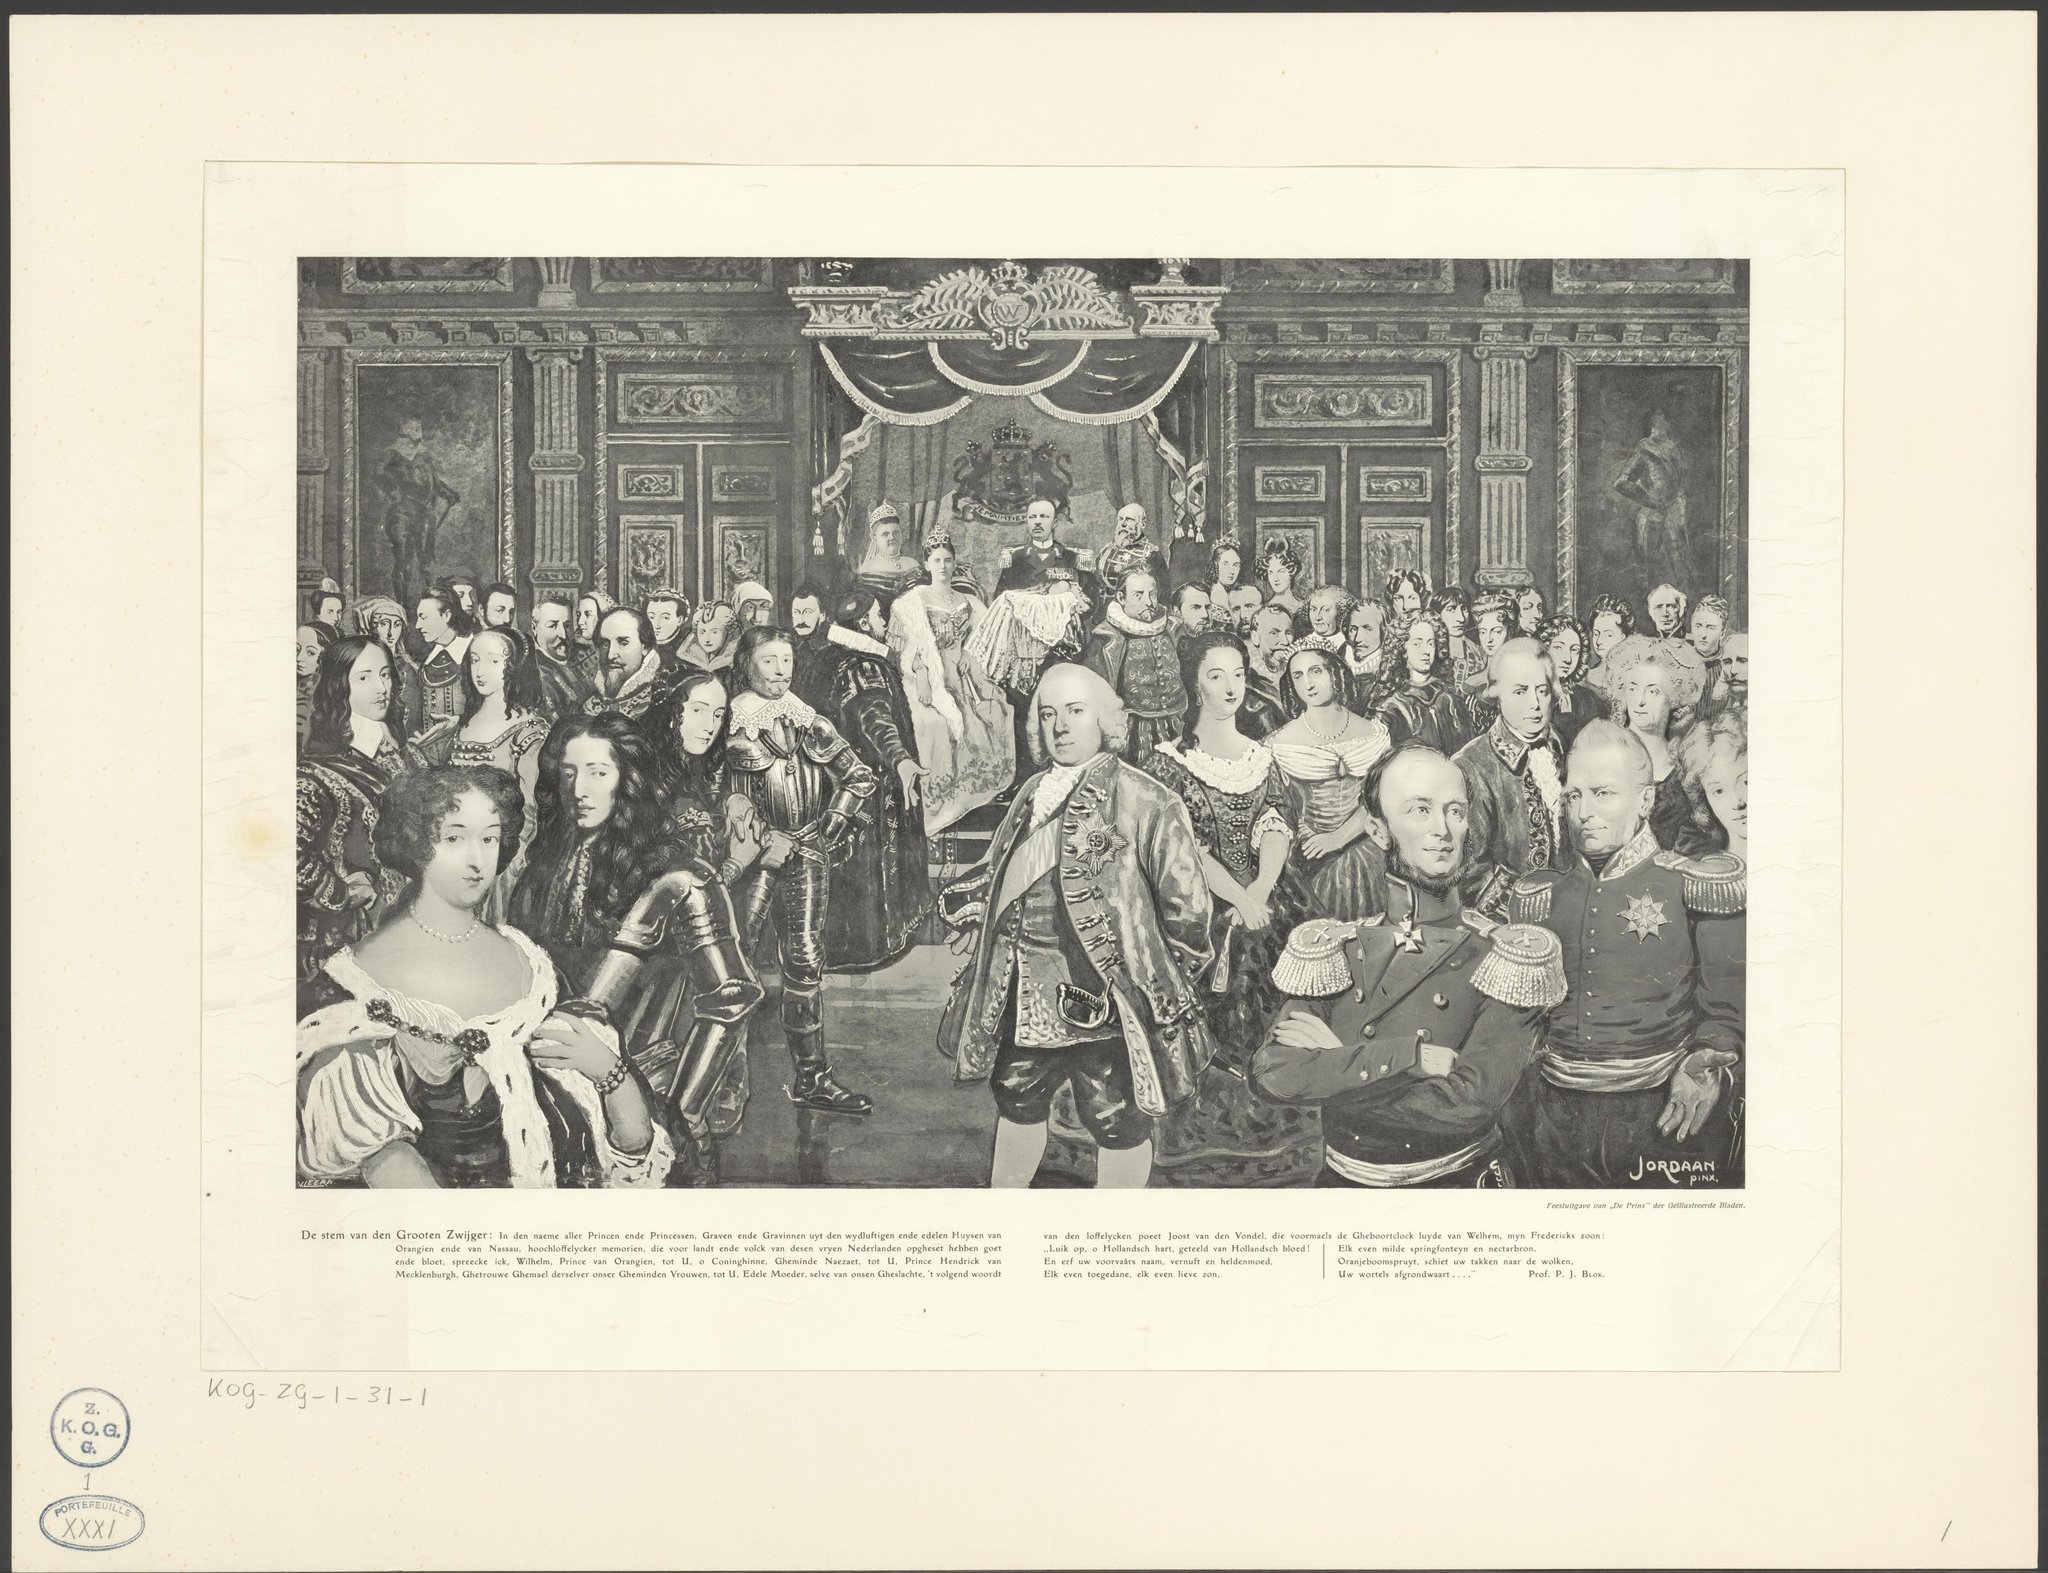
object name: photomechanical print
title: Feestuitgave bij de geboorte van prinses Juliana van "De Prins" der Geïllustreerde Bladen, 1909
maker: leendert jurriaan jordaan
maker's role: illustrator, karikaturist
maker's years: 1885-1980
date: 1909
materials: paper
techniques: autotype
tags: wilhelmina of the netherlands, hendrik (prins der nederlanden (1876-1934)), the hague, juliana of the netherlands, family group, especially parents with their child(ren), mother and baby or young child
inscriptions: collector's mark: Lugt 1641, stamp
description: Feestuitgave van "De Prins" der Geïllustreerde Bladen ter gelegenheid van de geboorte van prinses Juliana op 20 april 1909. De leden van het geslacht Oranje-Nassau bijeen in een zaal waarbij Willem van Oranje namens allen een groet brengt aan Koningin Wilhelmina en Prins Hendrik. Met onderschrift. Bij de prent behoort een sleutel met de namen van alle voorgestelden. Onderwerpsrubrieken binnen de Atlas Zeden en Gewoonten: Portretten, Portretten van Vorsten uit het huis van Oranje, Regeerende Vorsten, Stadhouders van Holland, Zeeland en West-Friesland.